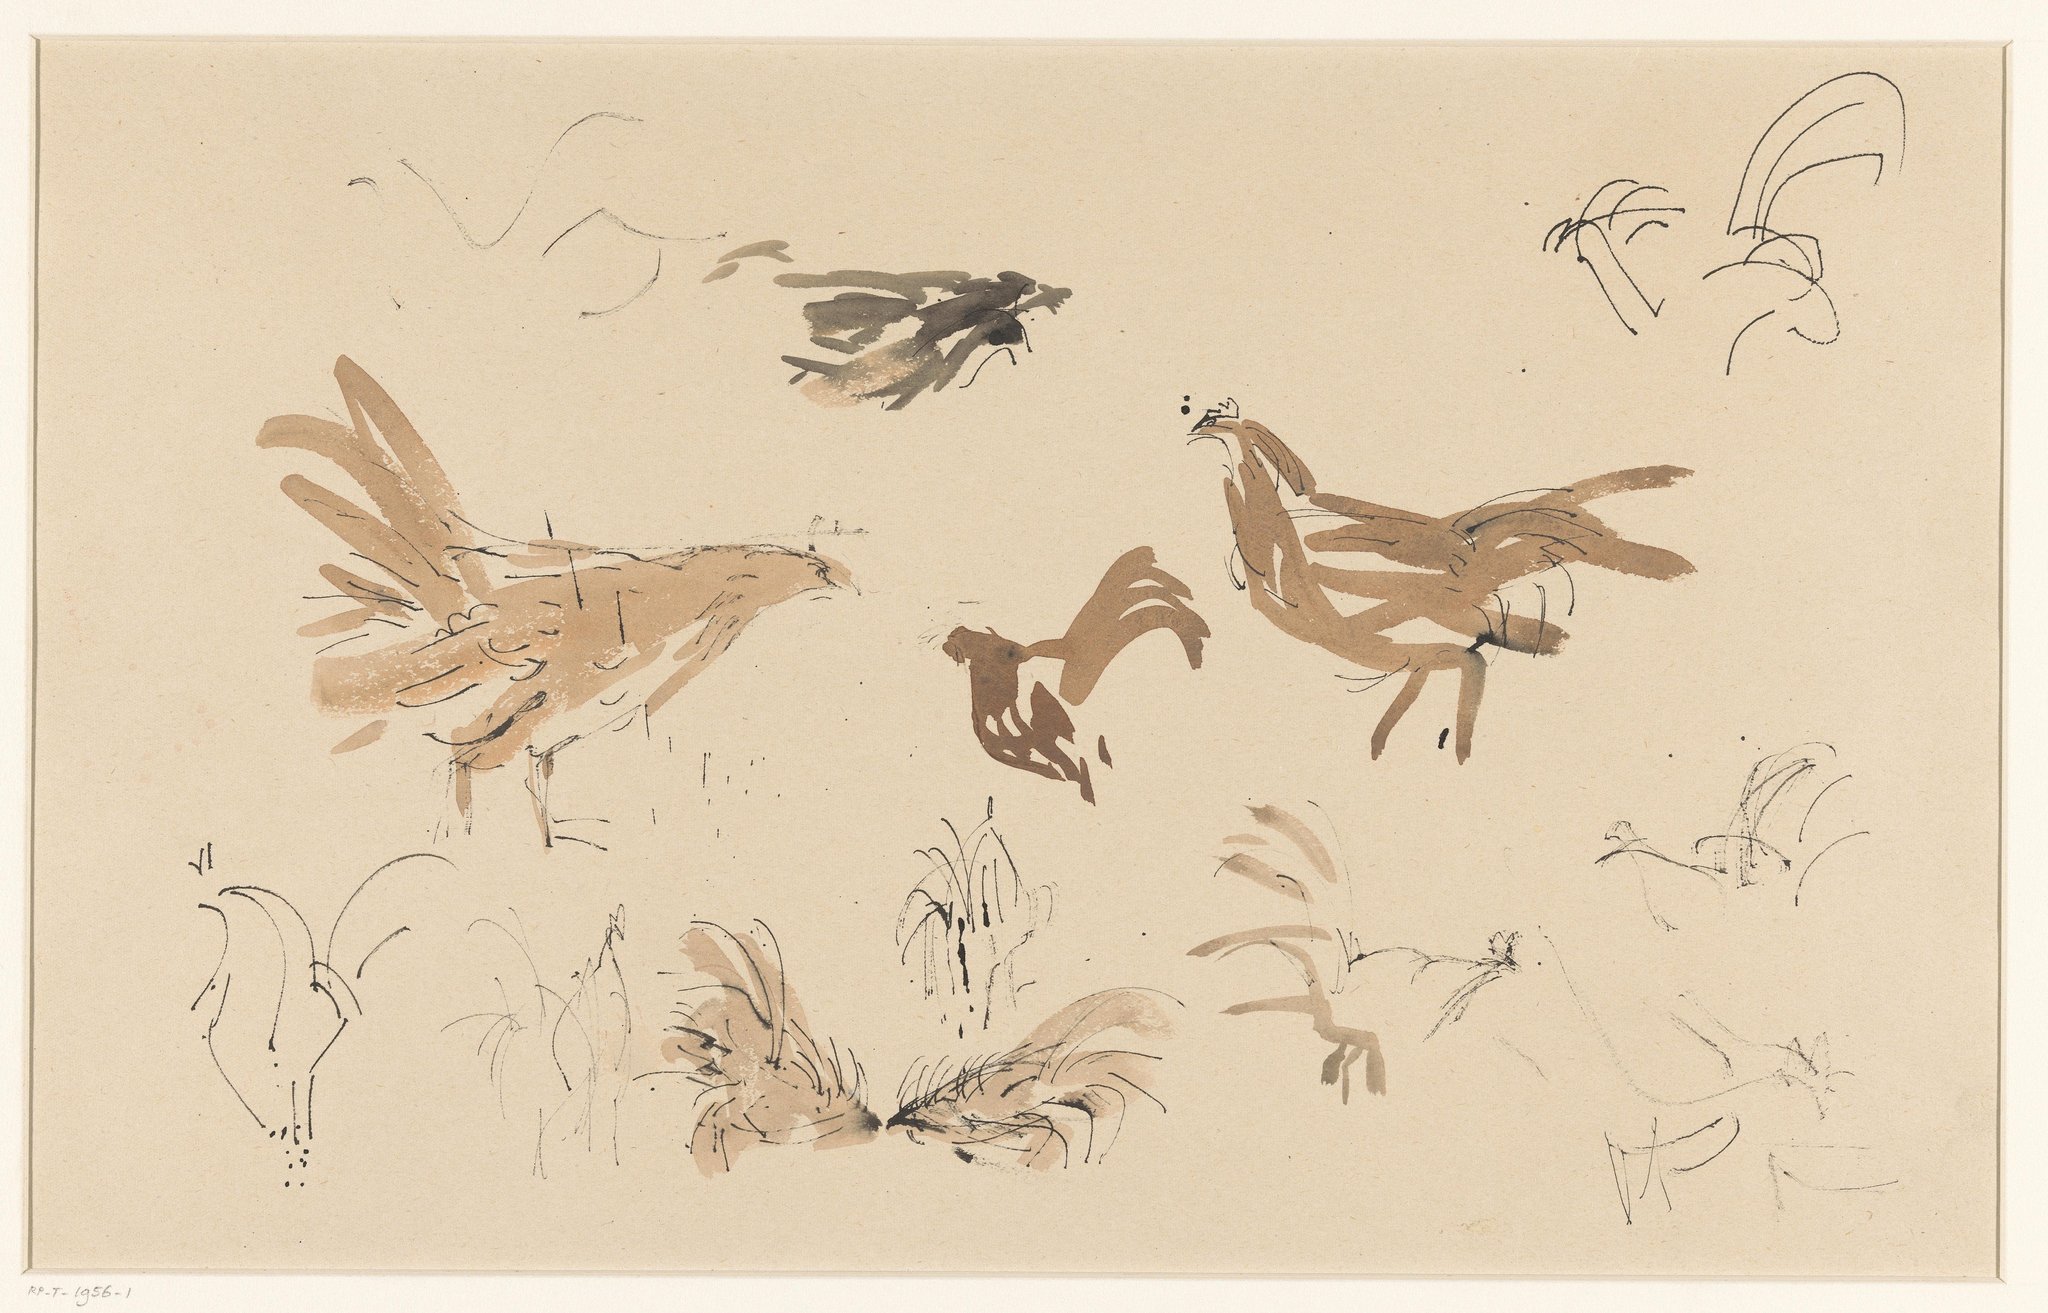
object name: drawing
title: Studieblad met hanen en delen van hanen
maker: q. halbertsma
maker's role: draughtsman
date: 1940-1956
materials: ink, paper, watercolor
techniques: brush, pen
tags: fowl (cock, hen, chicken, etc.)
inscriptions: collector's mark: Lugt 2228